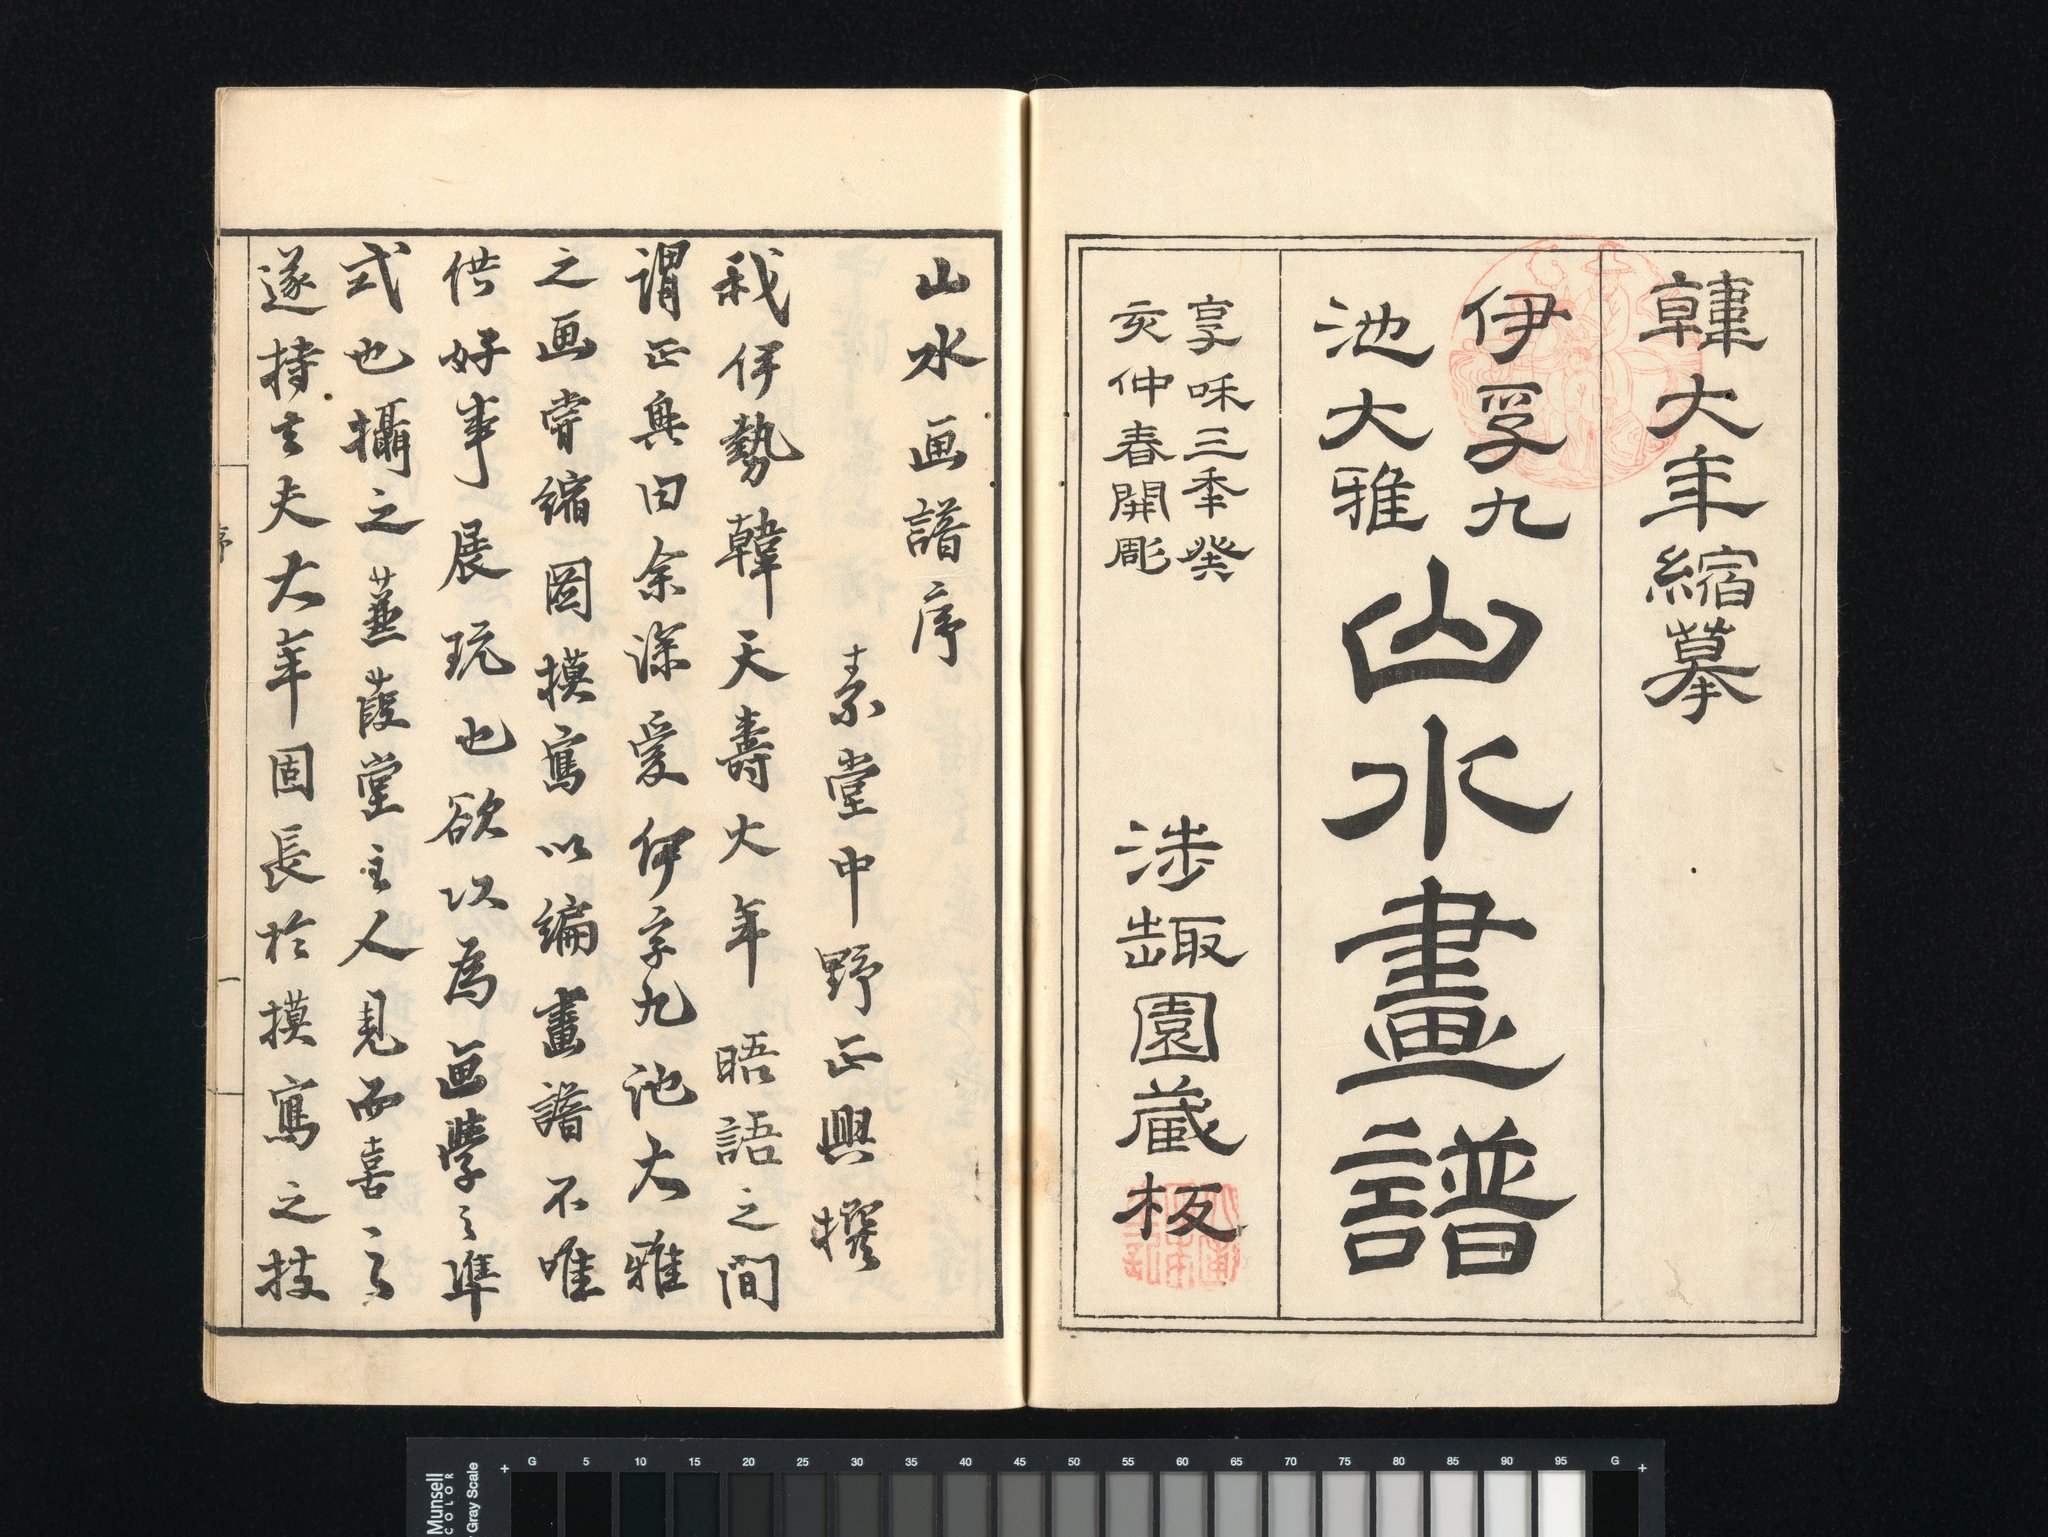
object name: illustrated book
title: Landscapes by I Fukyū (Yi Fujiu) and Ike no Taiga (I Fukyū Ike Taiga sansui gafu)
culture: japanese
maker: kan tenjū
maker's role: artist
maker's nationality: japanese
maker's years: 1727-1795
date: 1803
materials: ink, paper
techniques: woodblock print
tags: landscapes